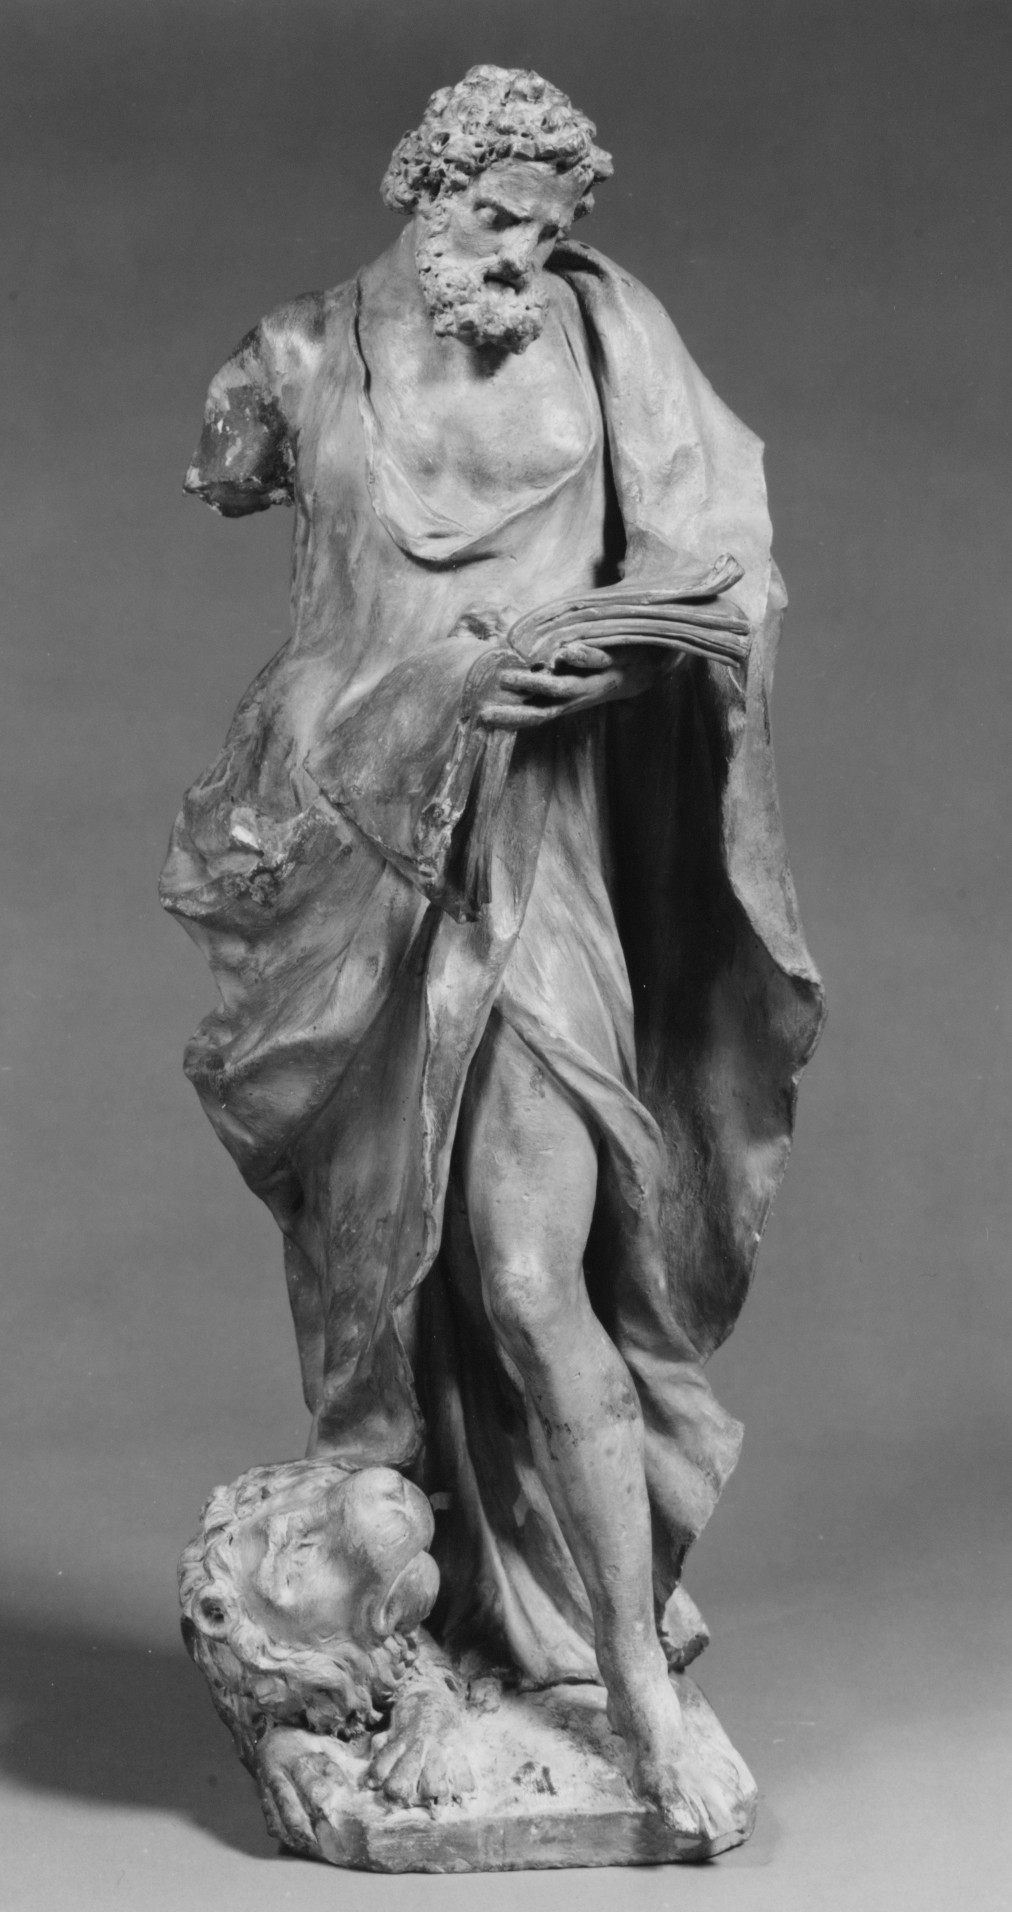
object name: statuette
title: Saint Mark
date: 1700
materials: terracotta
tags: saint mark